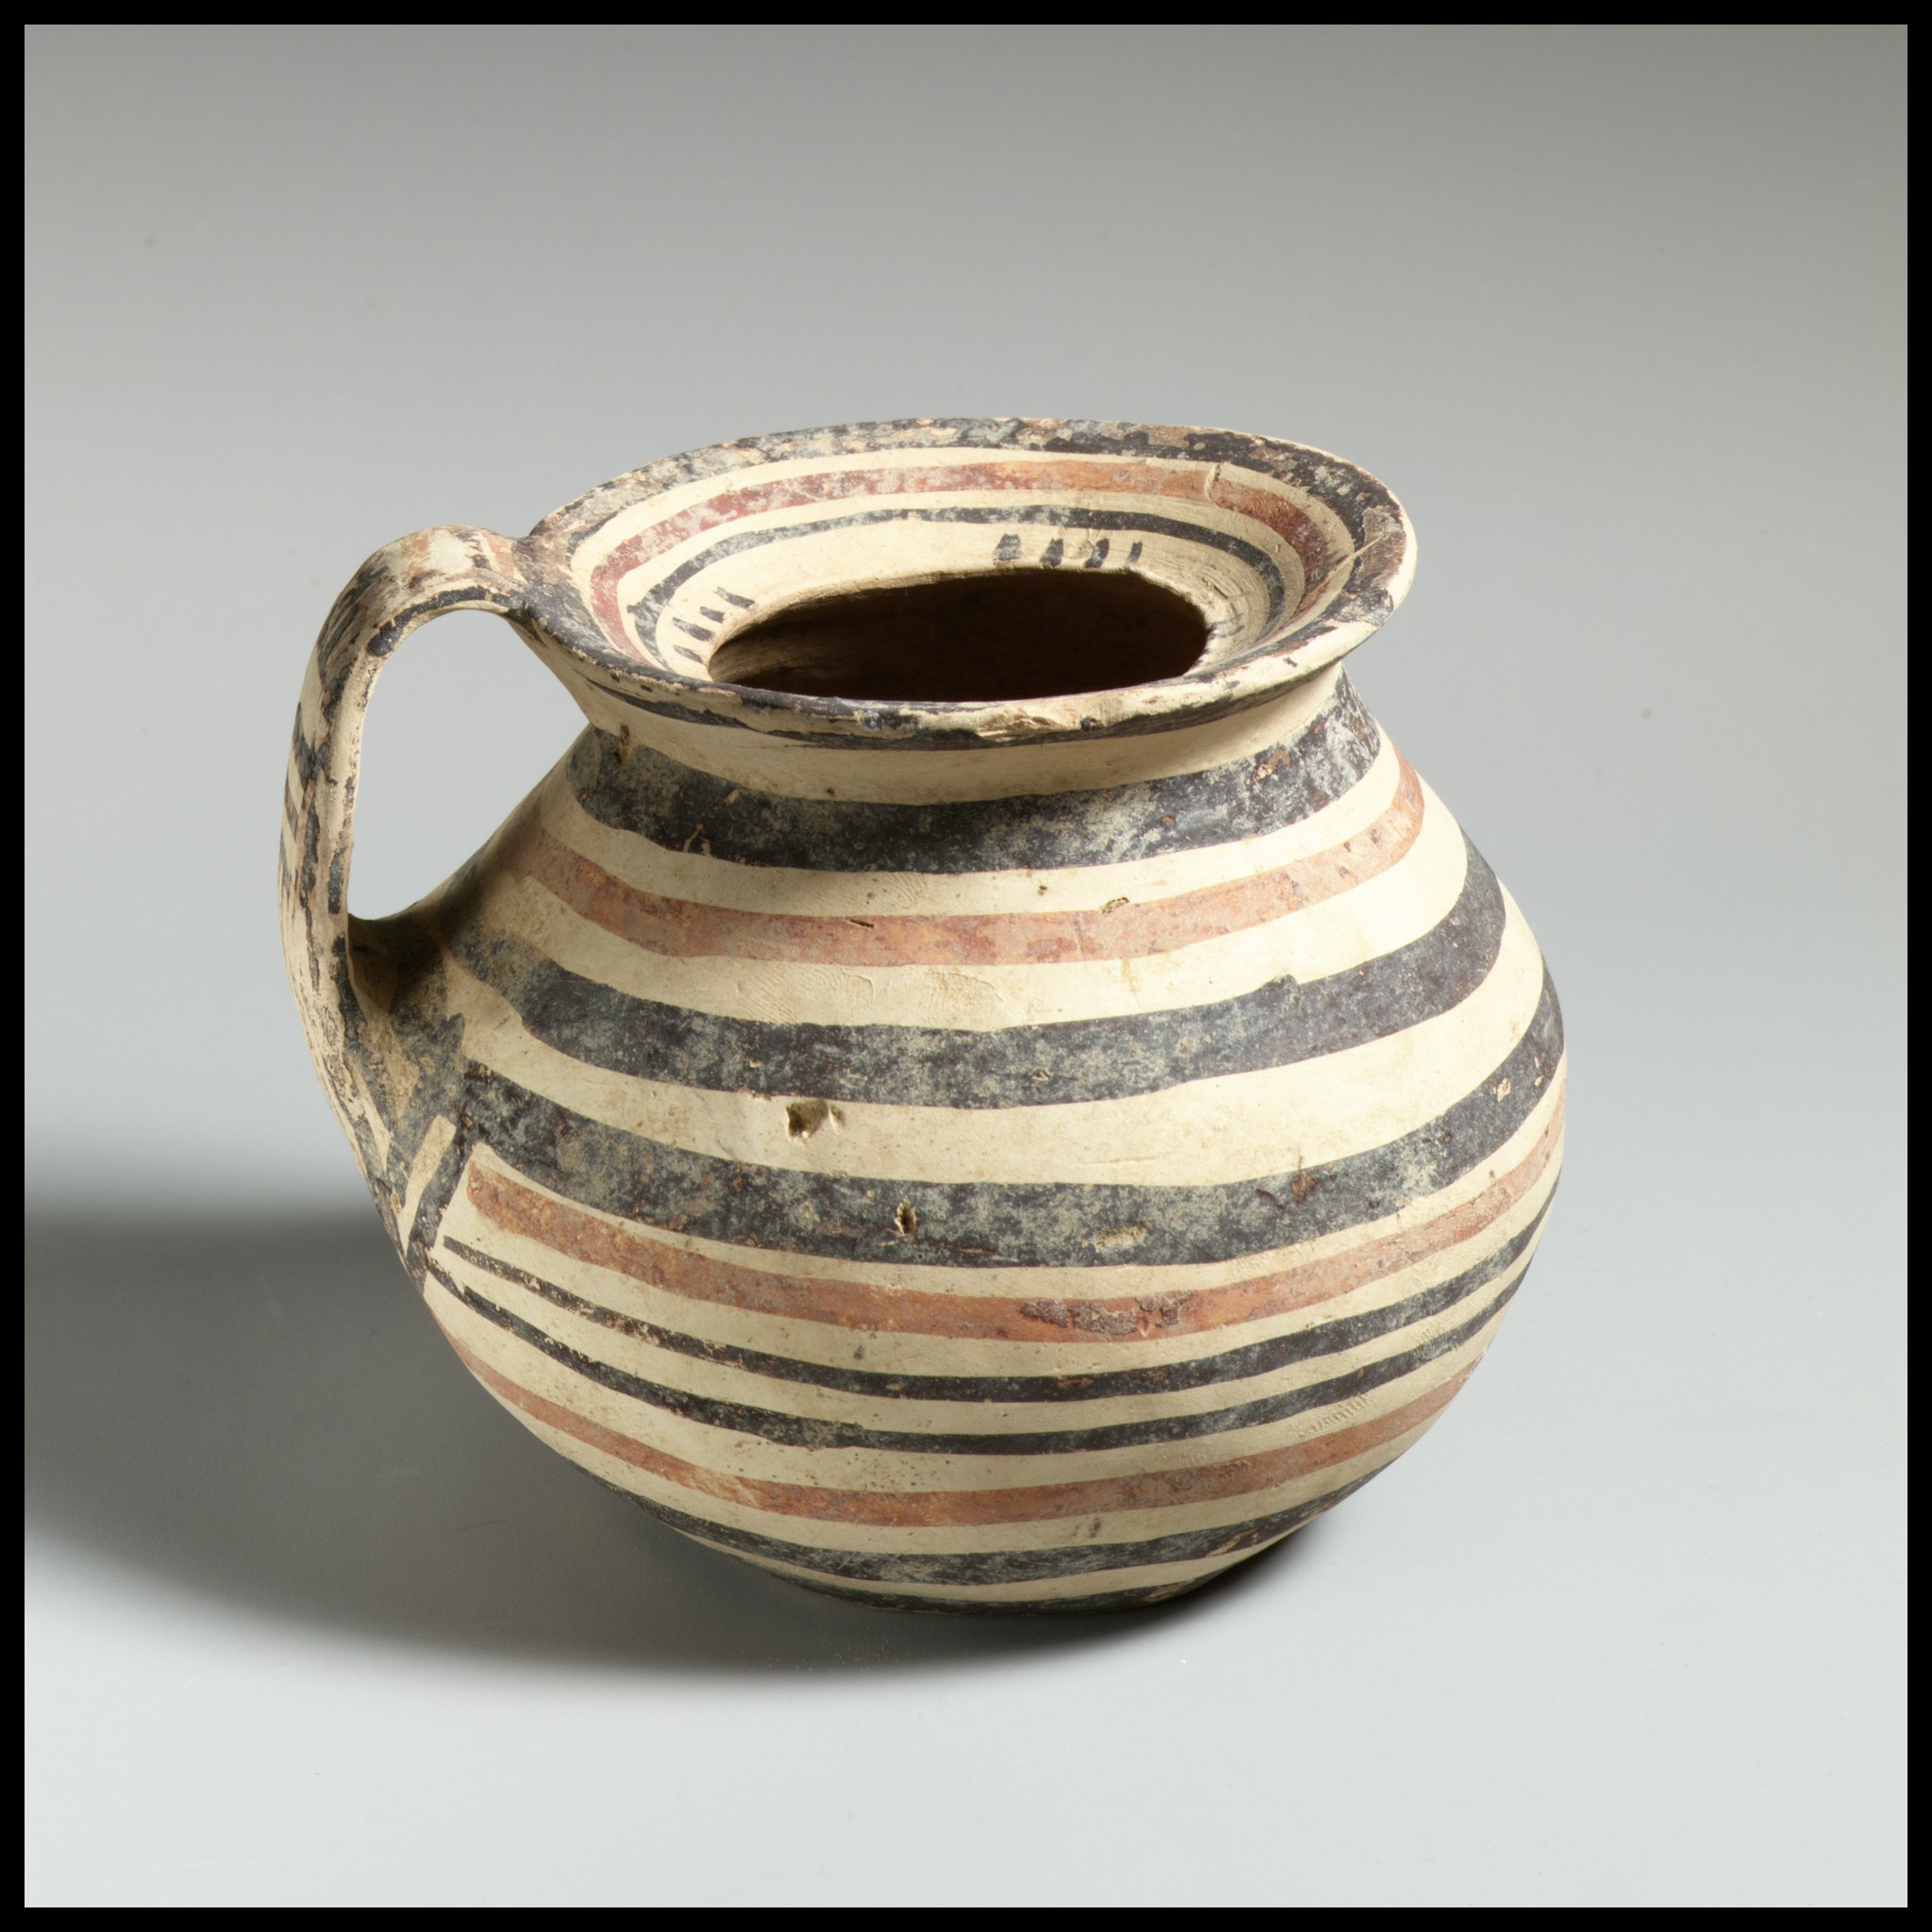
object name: jug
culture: italic, daunian or south italian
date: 550-450 BCE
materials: terracotta